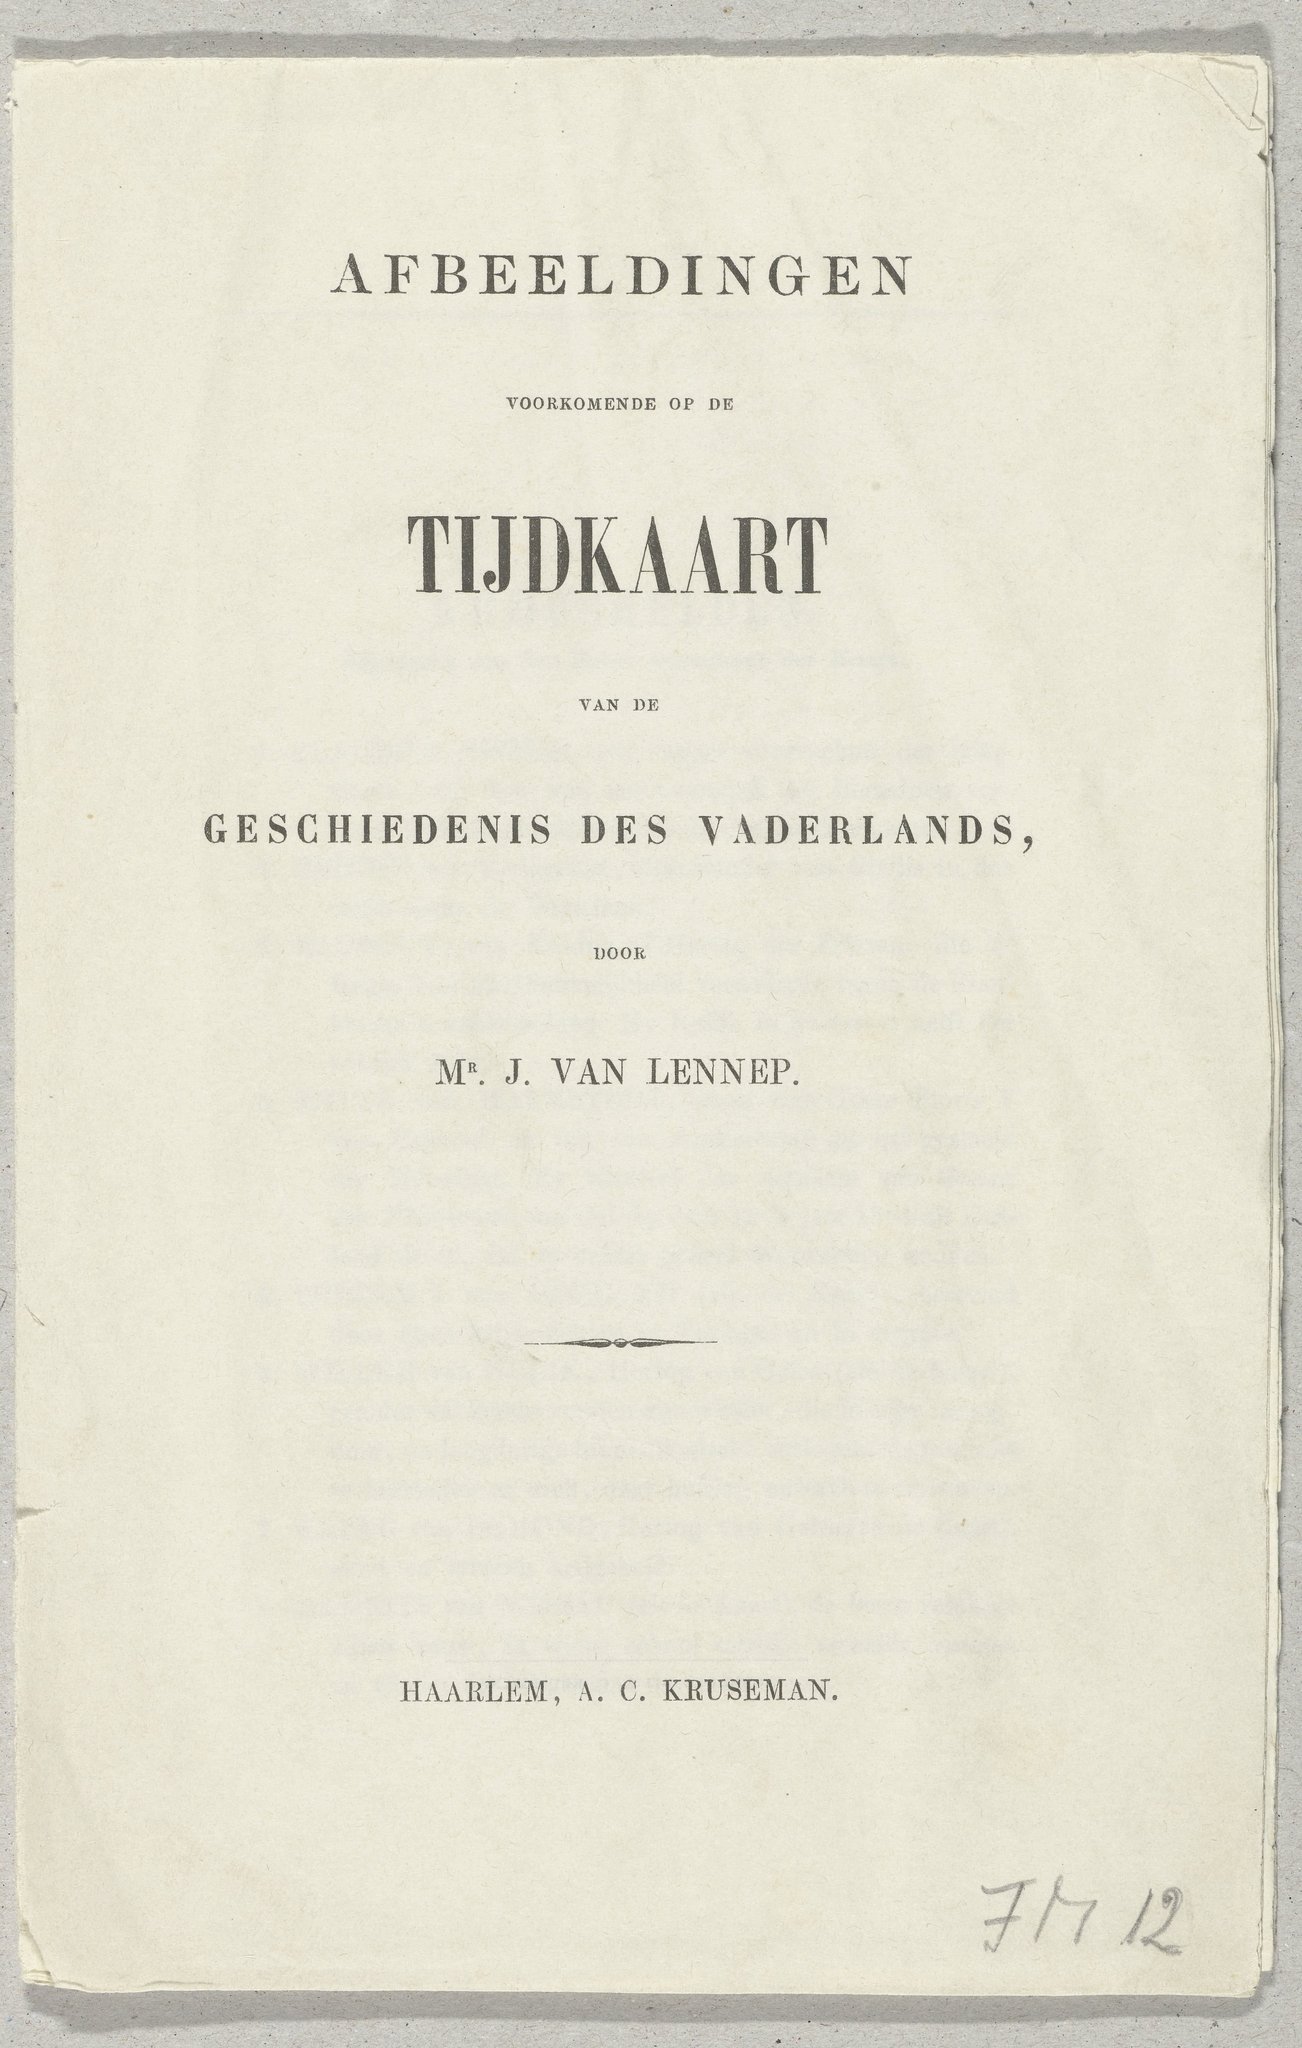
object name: printed matter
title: Tijdkaart der Geschiedenis van het Vaderland (boekje)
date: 1850-1855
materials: paper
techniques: printing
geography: netherlands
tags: netherlands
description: Boekje behorend bij de Tijdkaart der Geschiedenis van het Vaderland. Gedrukt boekje van 16 pagina's met uitleg en verklaring van alle cijfers voorkomend op de grote Tijdkaart met een overzicht van belangrijke jaartallen en gebeurtenissen in de geschiedenis van Nederland, krijgshelden, dichters en geleerden, staatslieden en volksverlichters en kunstbeoefenaars. Vanaf Karel de Grote tot aan koning Willem III.